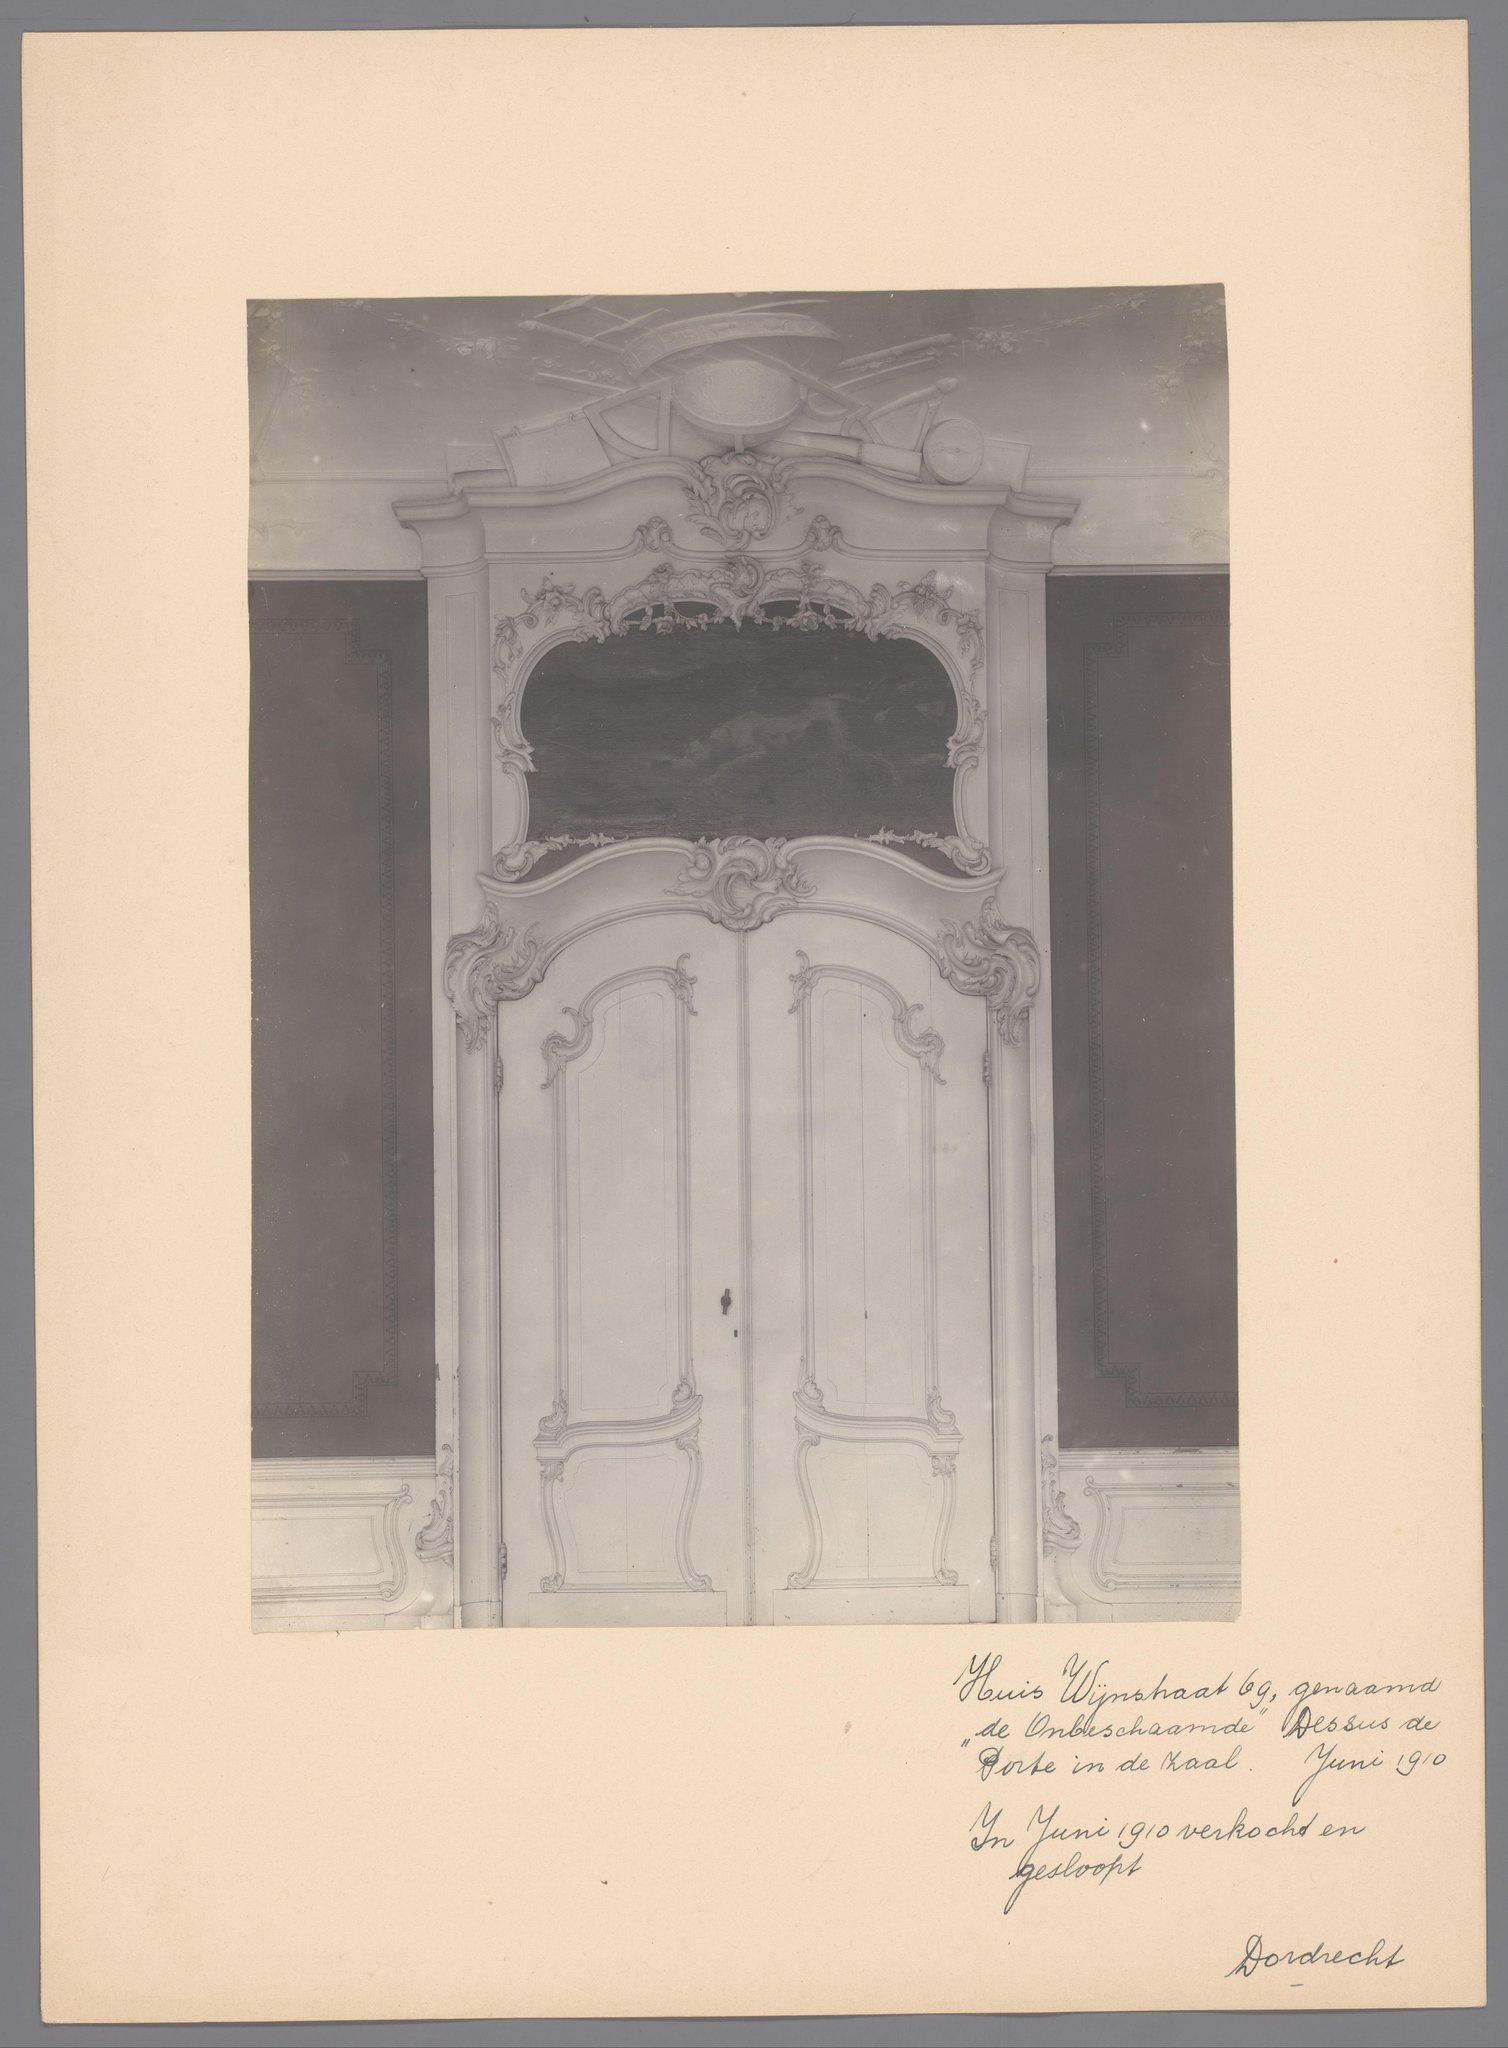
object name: photograph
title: Dessus-de-porte met een afbeelding van een hond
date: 1910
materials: cardboard, photographic support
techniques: gelatin silver print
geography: wijnstraat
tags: door, interior of the house, picture, painting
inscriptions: annotation: ‘Huis Wijnstraat 69, genaamd "de onbeschaamde" Dessus de Porte in de zaal/ Juni 1910/ In Juni 1910 verkocht en gesloopt/ Dordrecht’